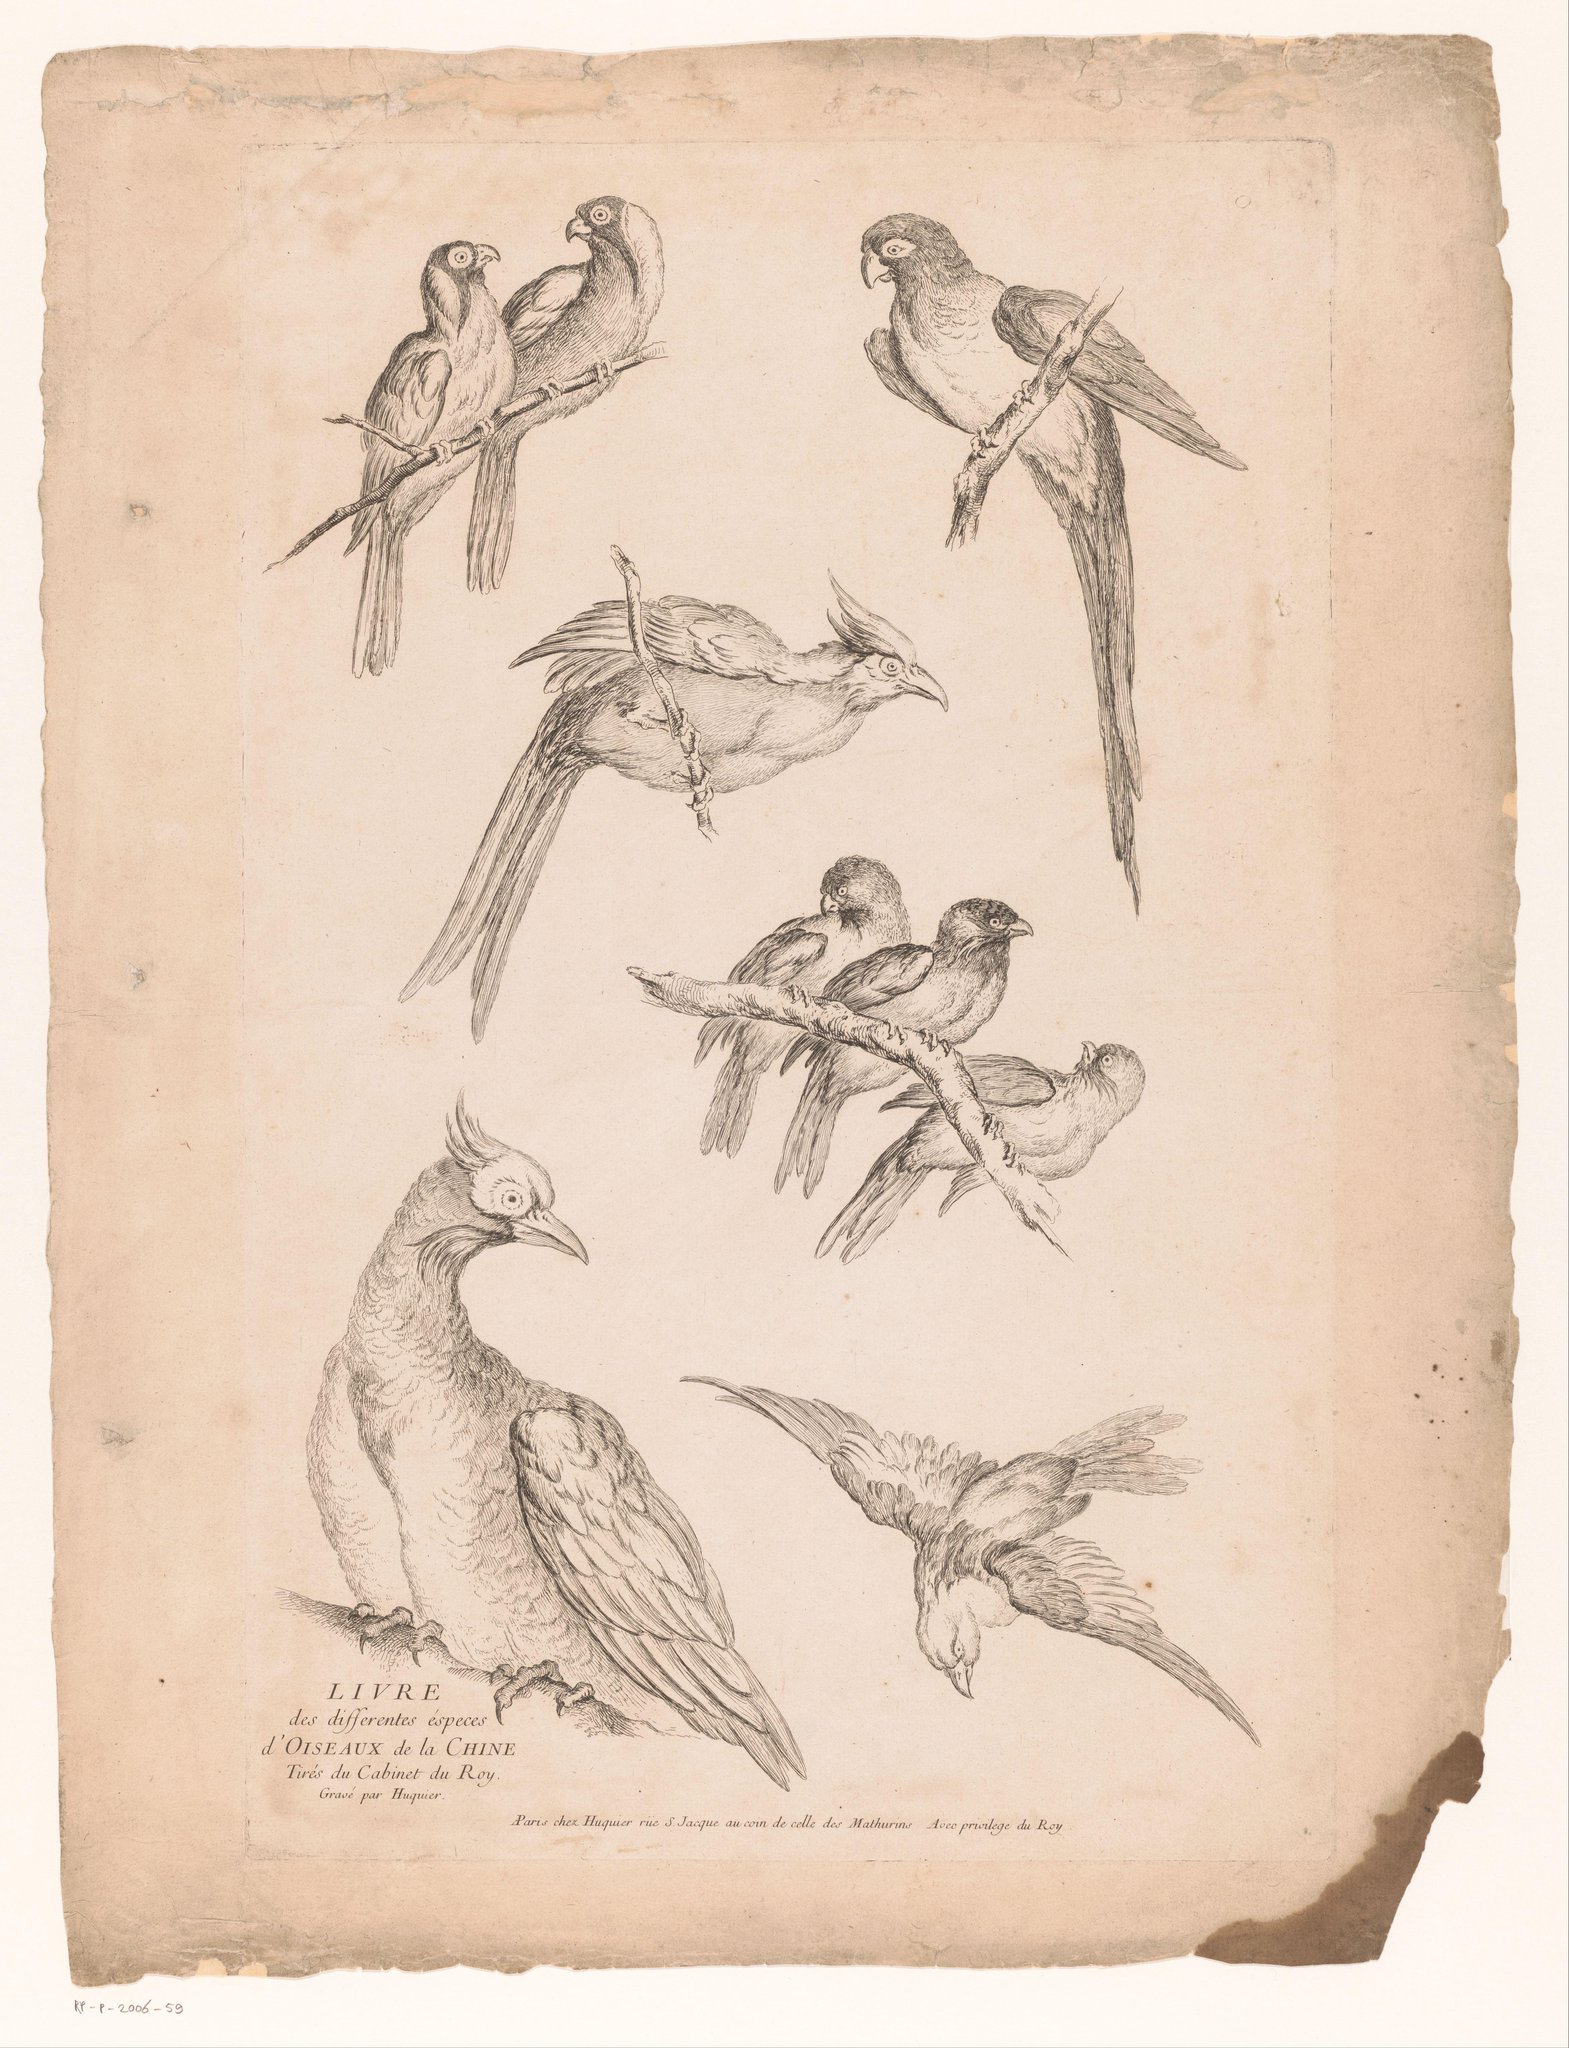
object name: ornament print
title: Negen Chinese vogels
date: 1742-1750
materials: paper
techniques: etching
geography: france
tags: birds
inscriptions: title: ‘LIVRE // des differentes éspeces // d'OISEAUX de la CHINE // Tirés du Cabinet du Roy’, collector's mark: Lugt 2760, collector's mark: Lugt 2228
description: Titelprent van een vijftiendelige serie met prenten van vogels uit China.